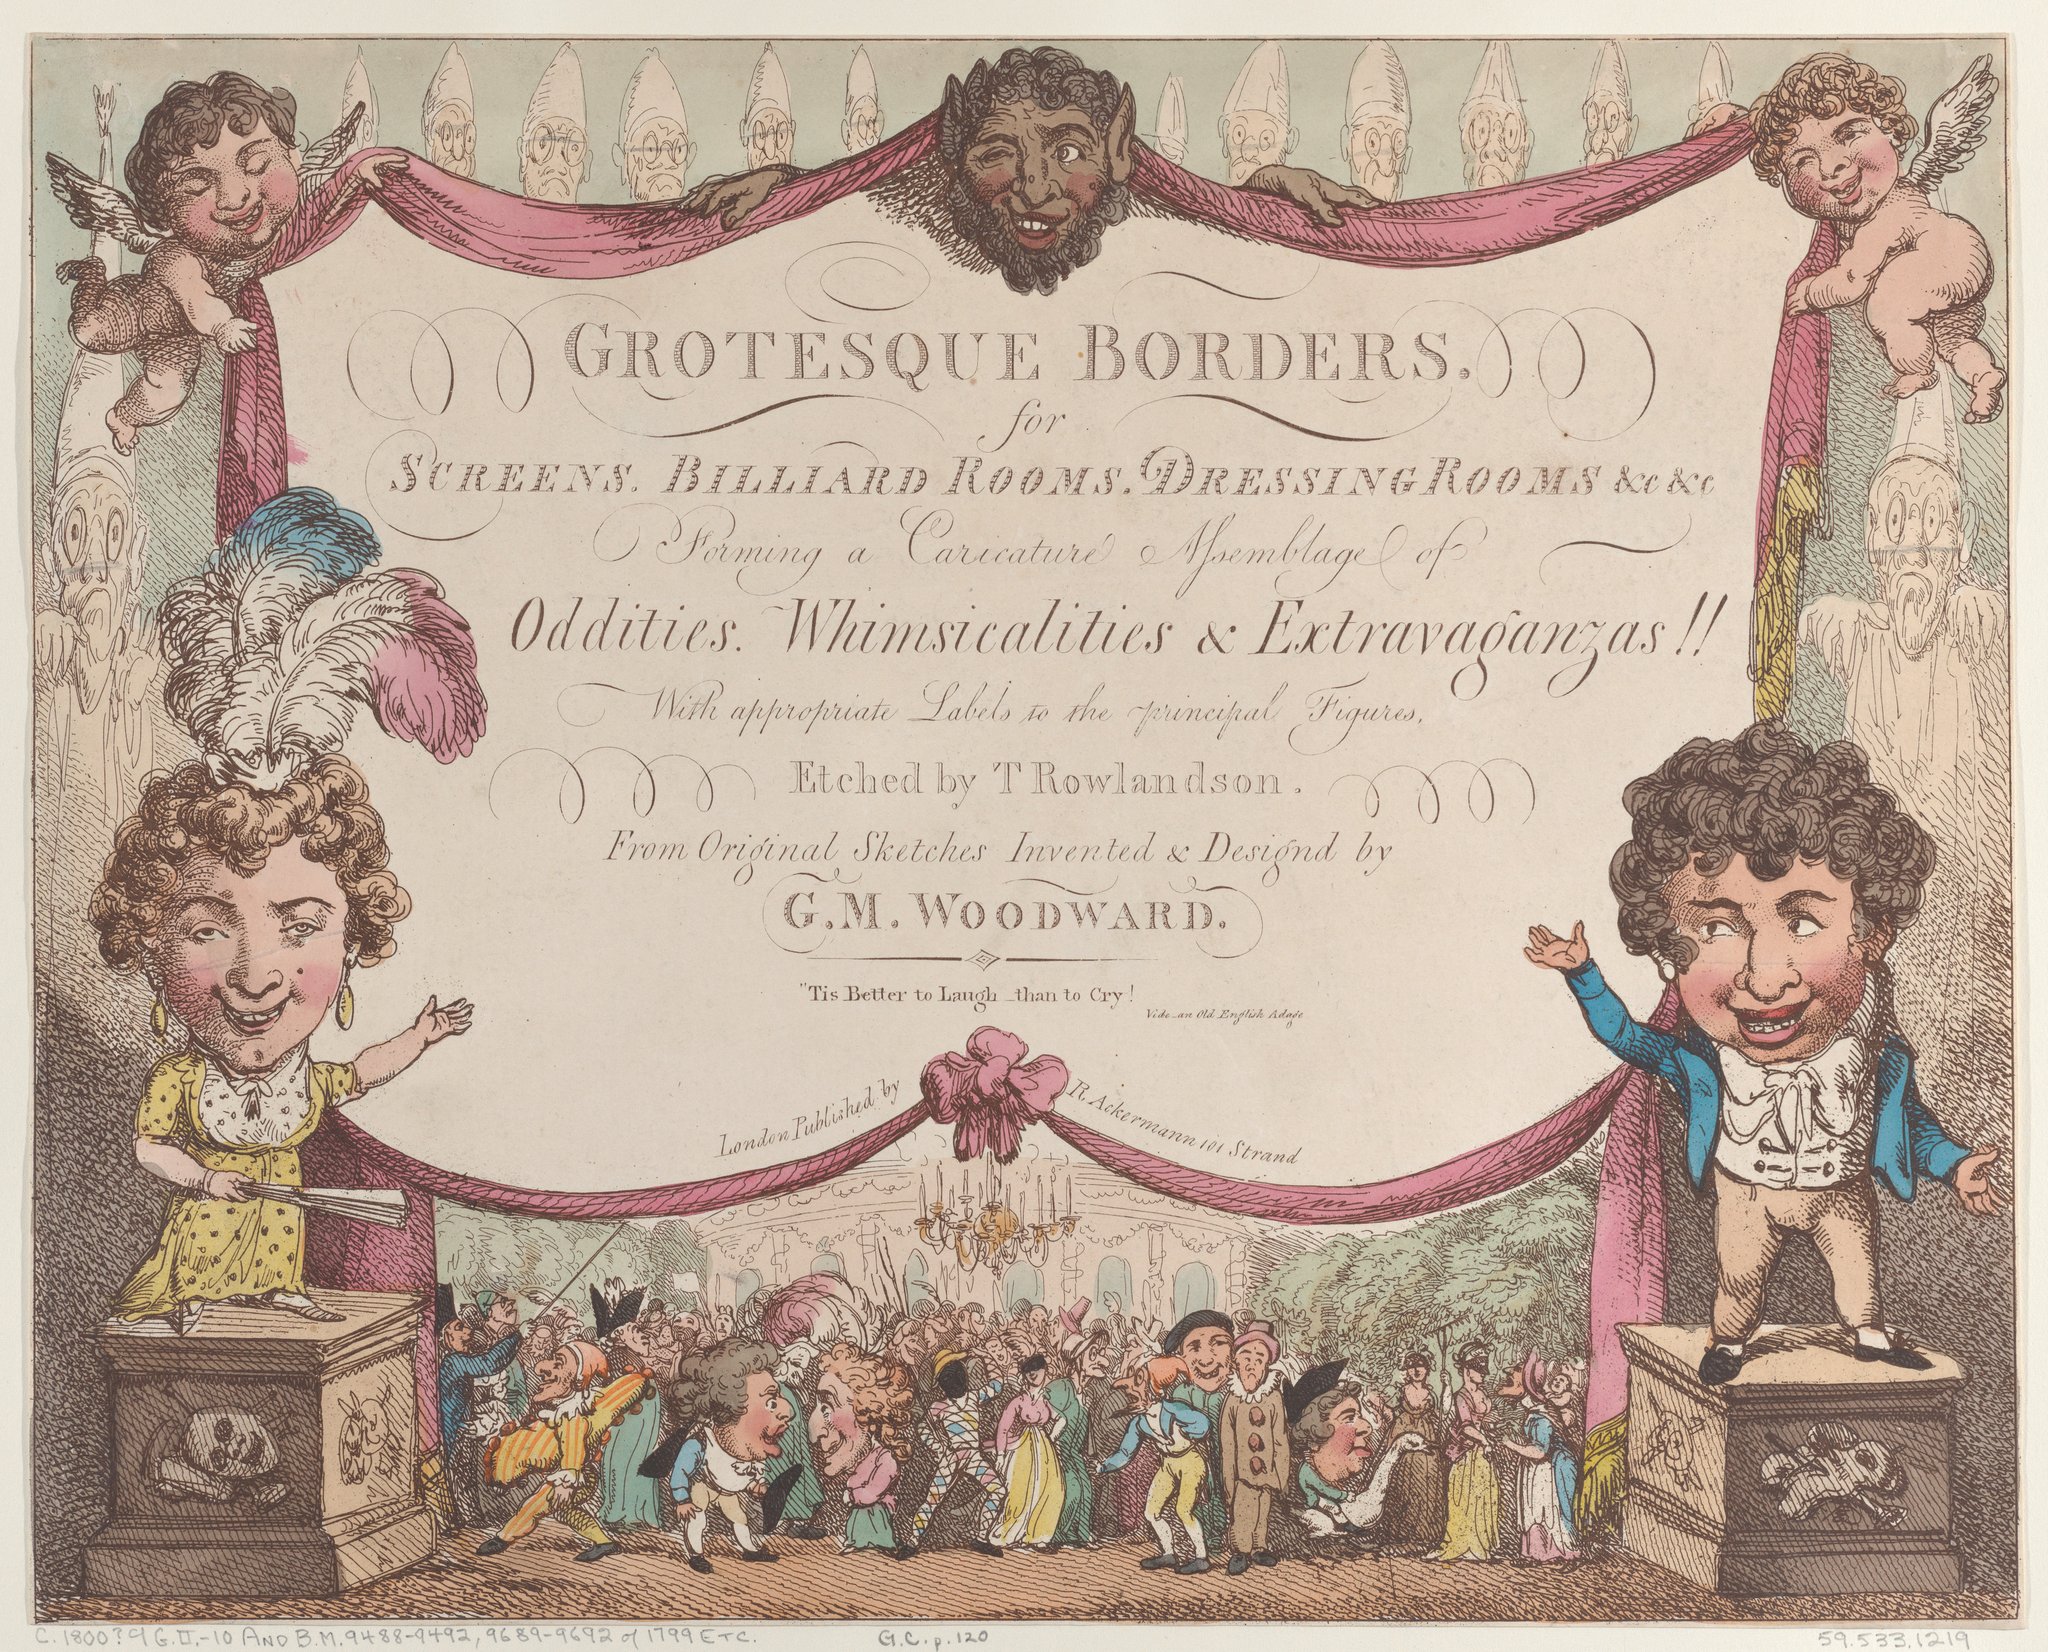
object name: print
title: Grotesque Borders for Screens, Billiard Rooms, Dressing Rooms, &c &c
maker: thomas rowlandson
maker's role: artist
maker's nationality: british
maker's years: 1757-1827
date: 1799-1800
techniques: etching